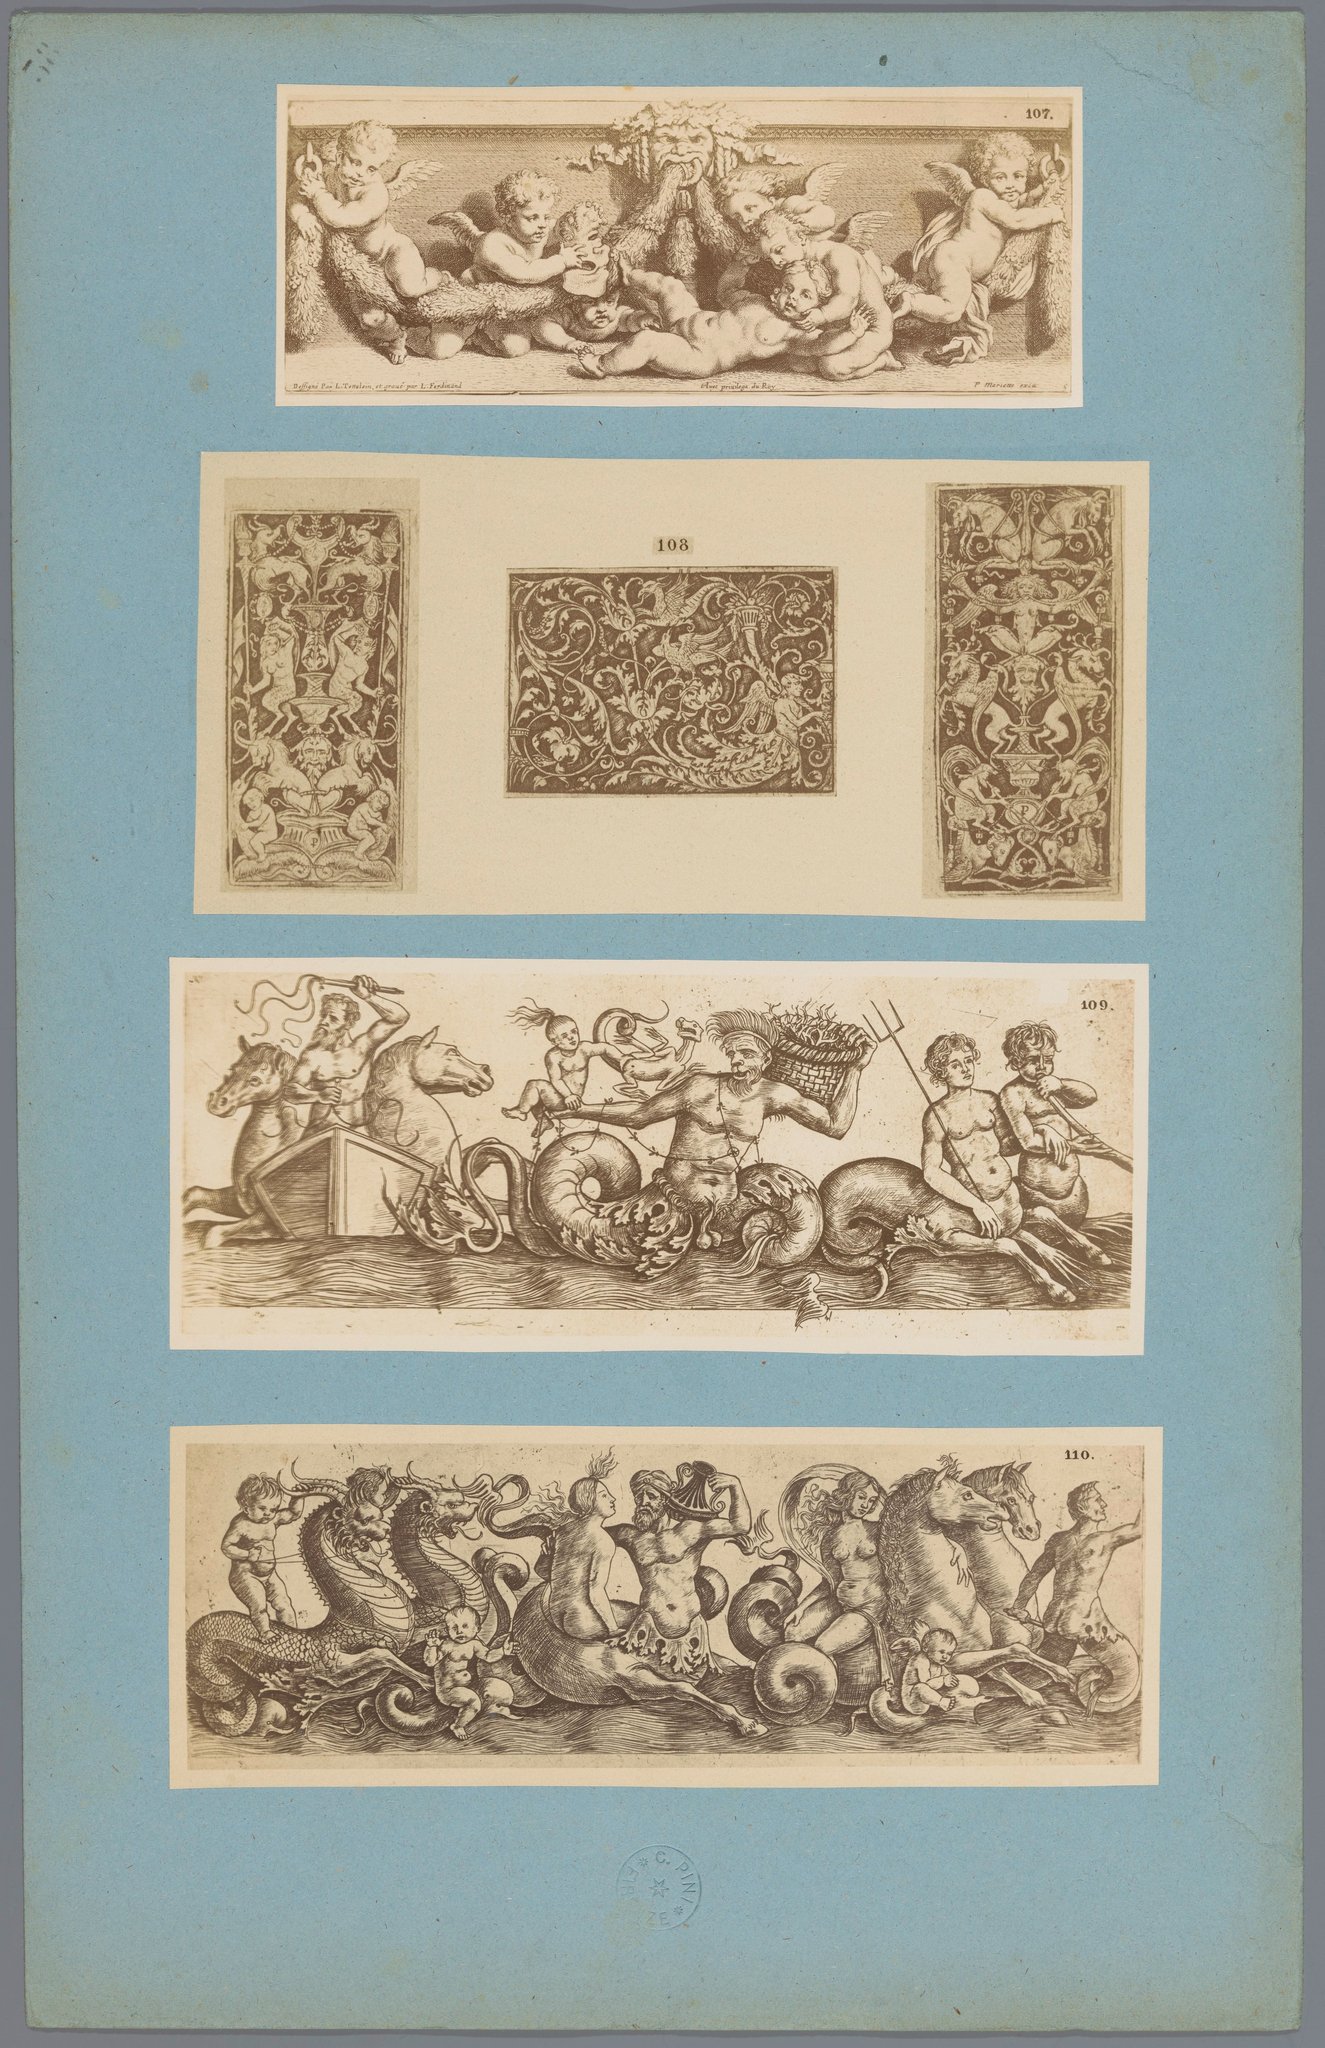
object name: reproduction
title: Vier fotoreproducties van prenten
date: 1875-1900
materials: cardboard, photographic support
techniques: albumen print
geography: europe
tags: (story of) neptune (poseidon), ornament ~ hybrid animals, print, e.g.: engraving, etching, lithograph, cupids: 'amores', 'amoretti', 'putti', europe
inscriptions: number: ‘108.’, number: ‘110.’, collector's mark: Lugt 3937, name: ‘C. Pini Firenze’, number: ‘38’, number: ‘109.’, number: ‘107.’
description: Boven (107) prent met zeven putti door L. Ferdinand, tweede van boven (108) drie voorstellingen met fabeldieren, tweede van onder (109) prent van vermoedelijk Poseidon, onder (110) prent met zeemonsters en zeegoden.